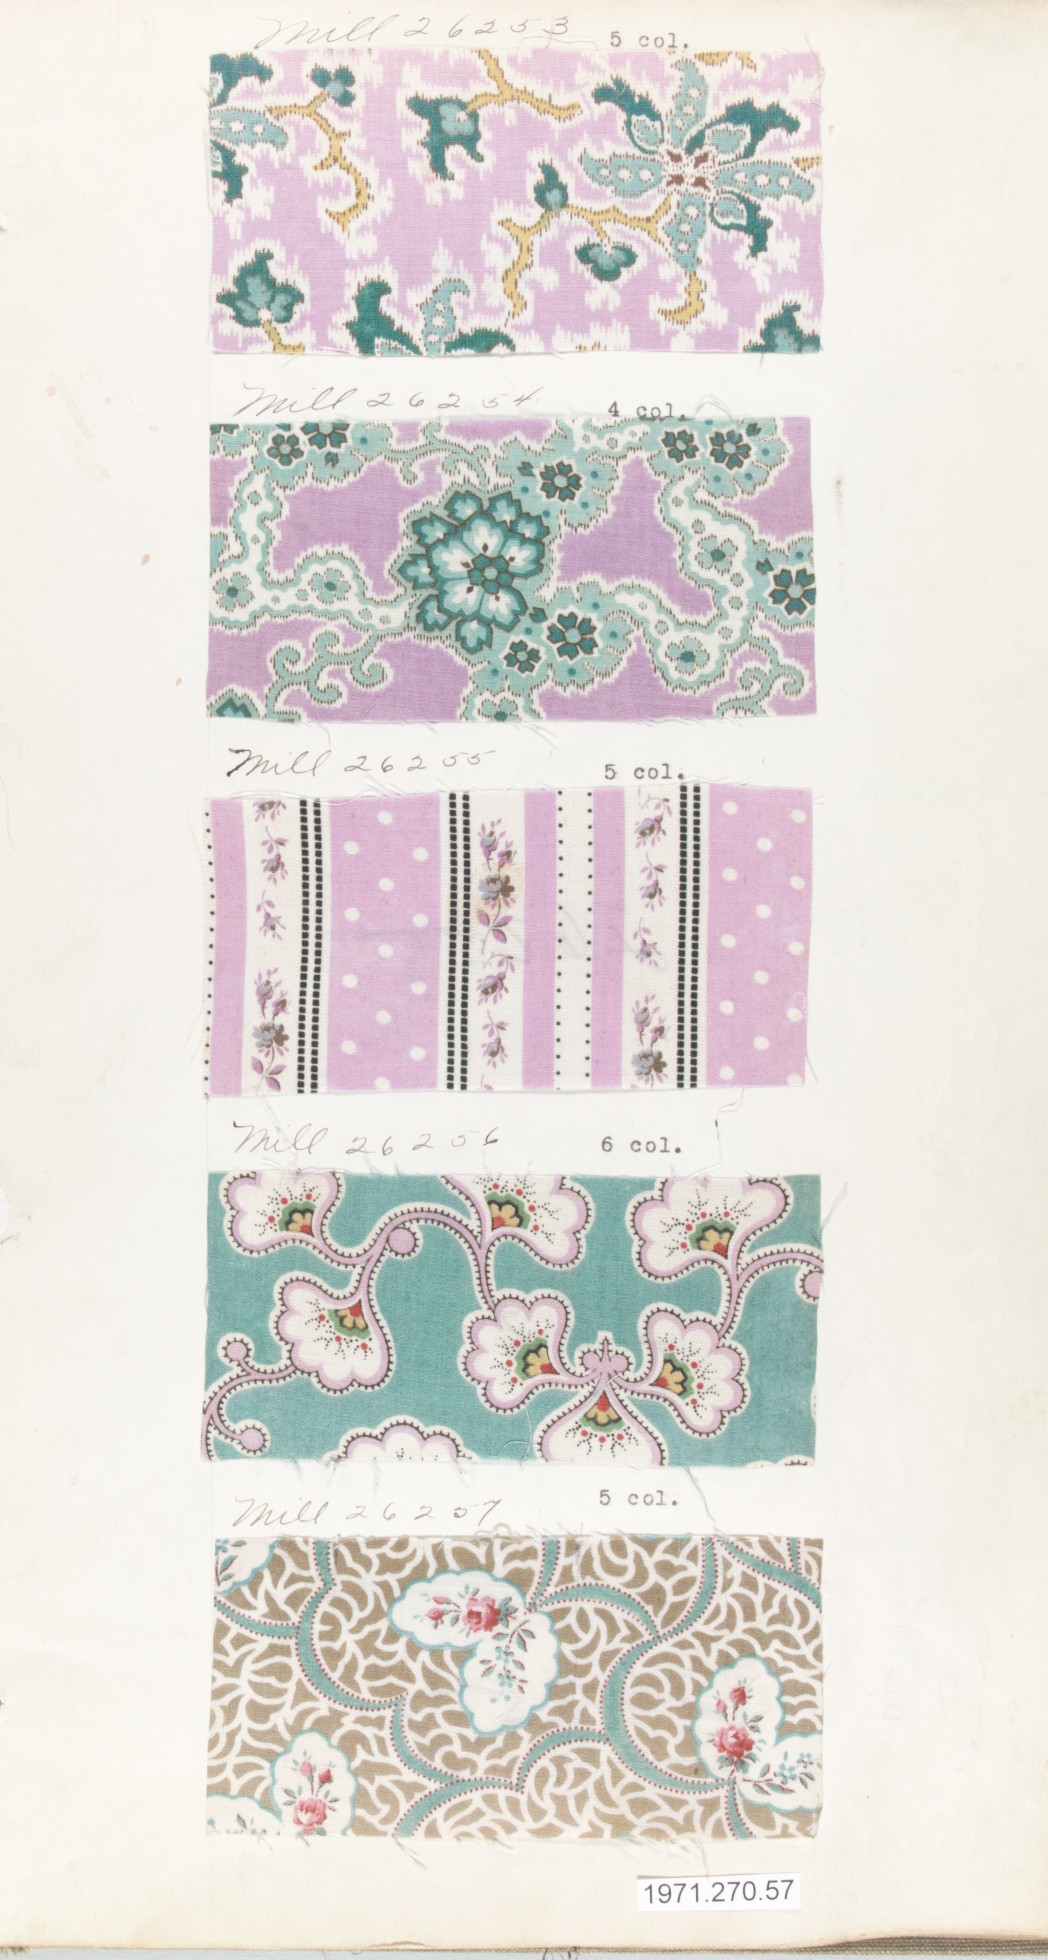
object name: sample book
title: Textile Sample Book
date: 1870-1879